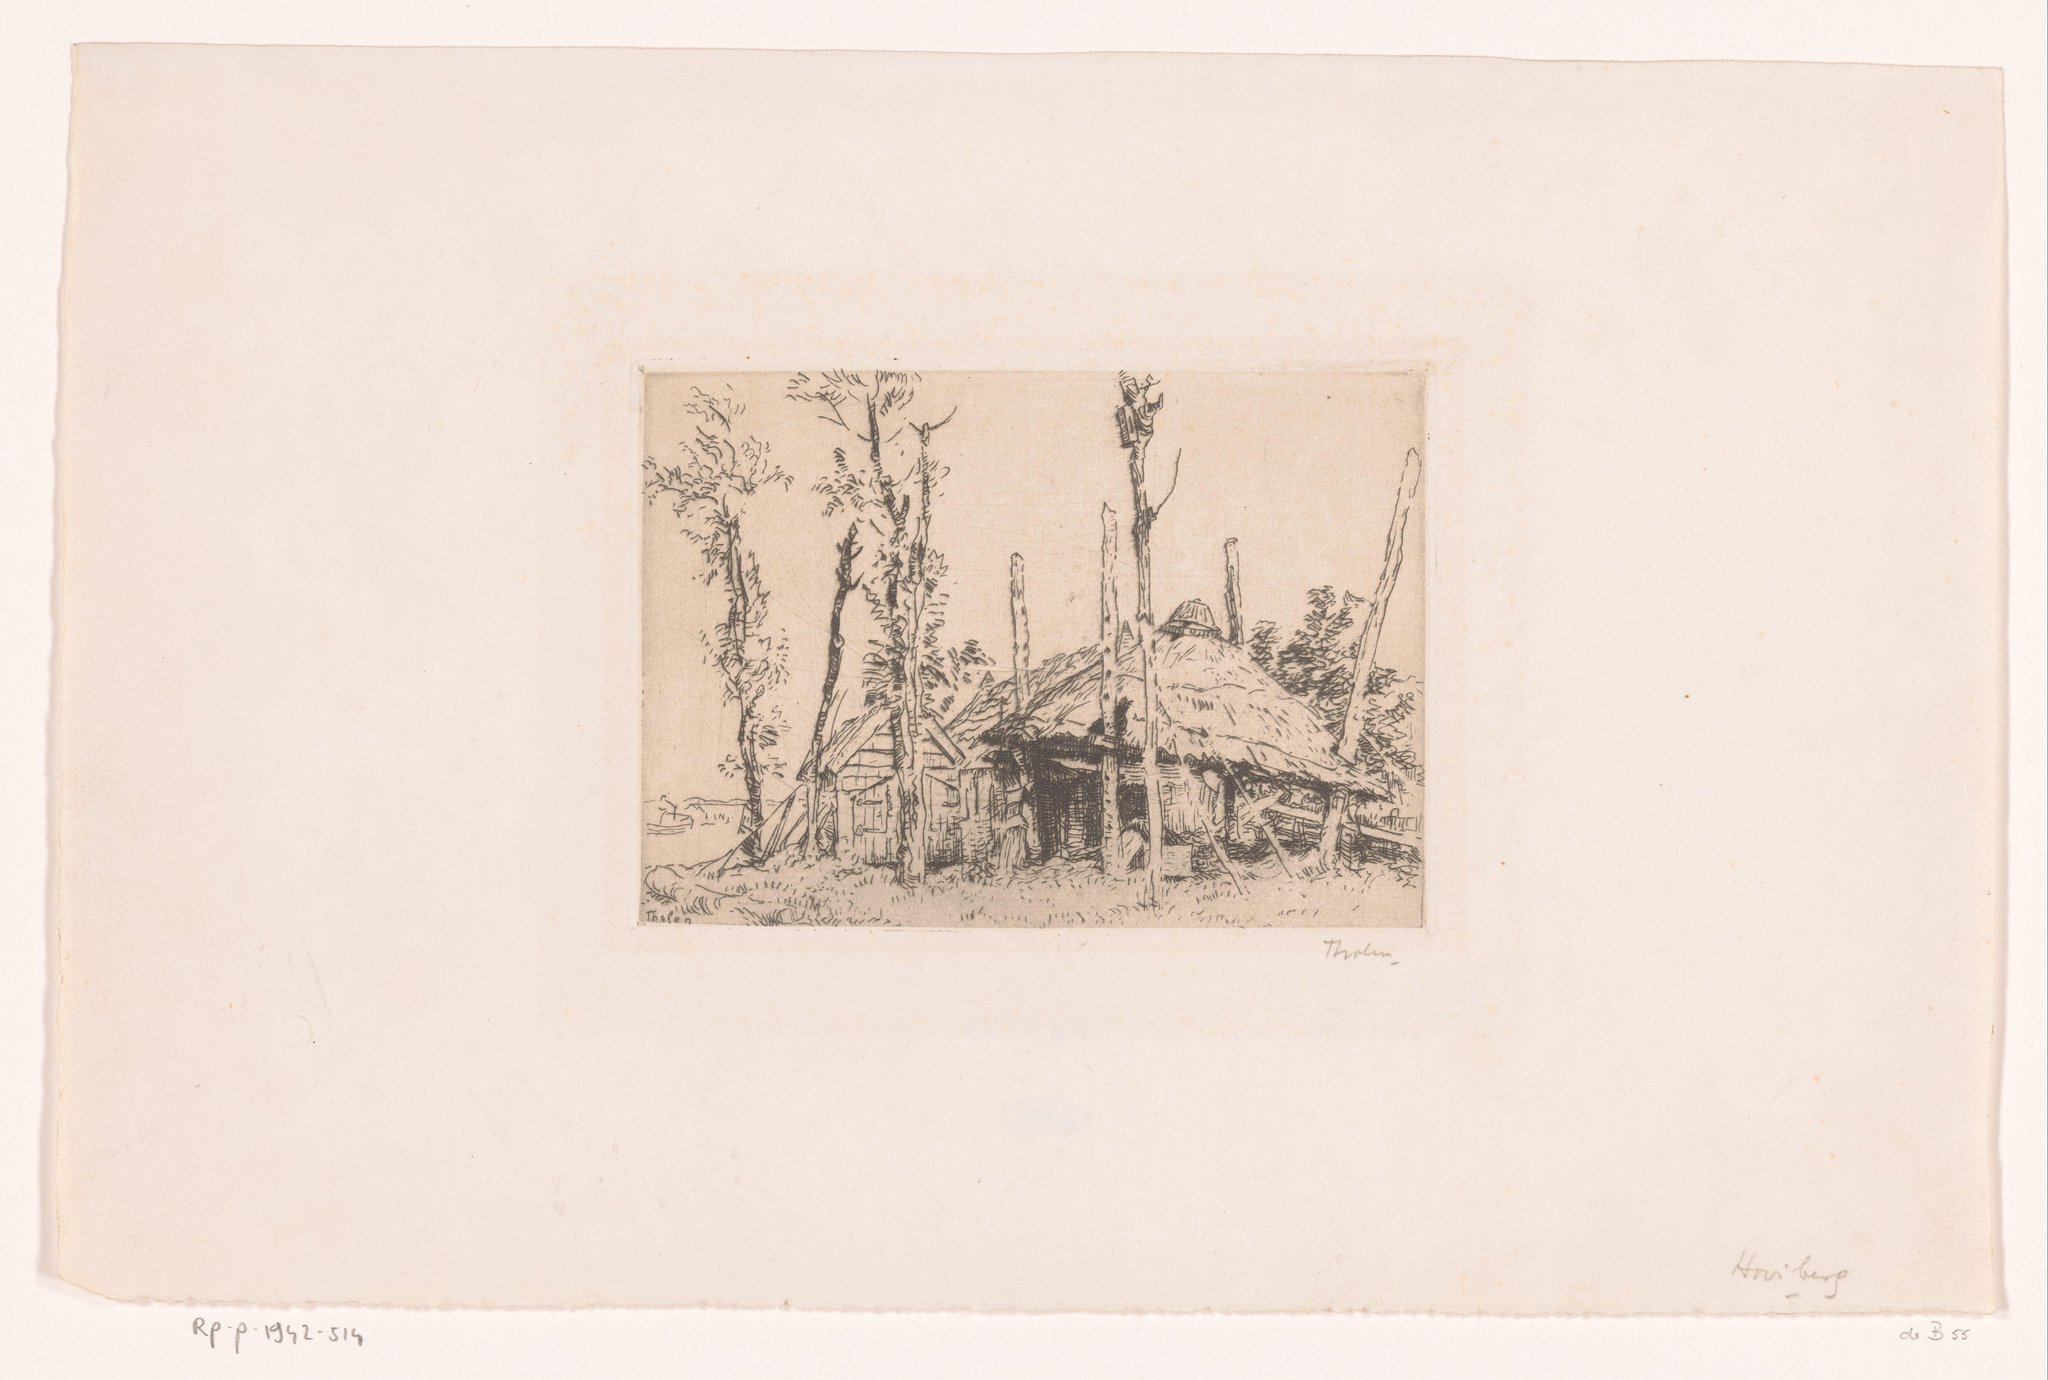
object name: print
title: Hooischelf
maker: willem bastiaan tholen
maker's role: draughtsman, painter, print maker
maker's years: 1860-1931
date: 1870-1914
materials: paper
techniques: etching, intaglio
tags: hay-stack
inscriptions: collector's mark: Lugt 2228